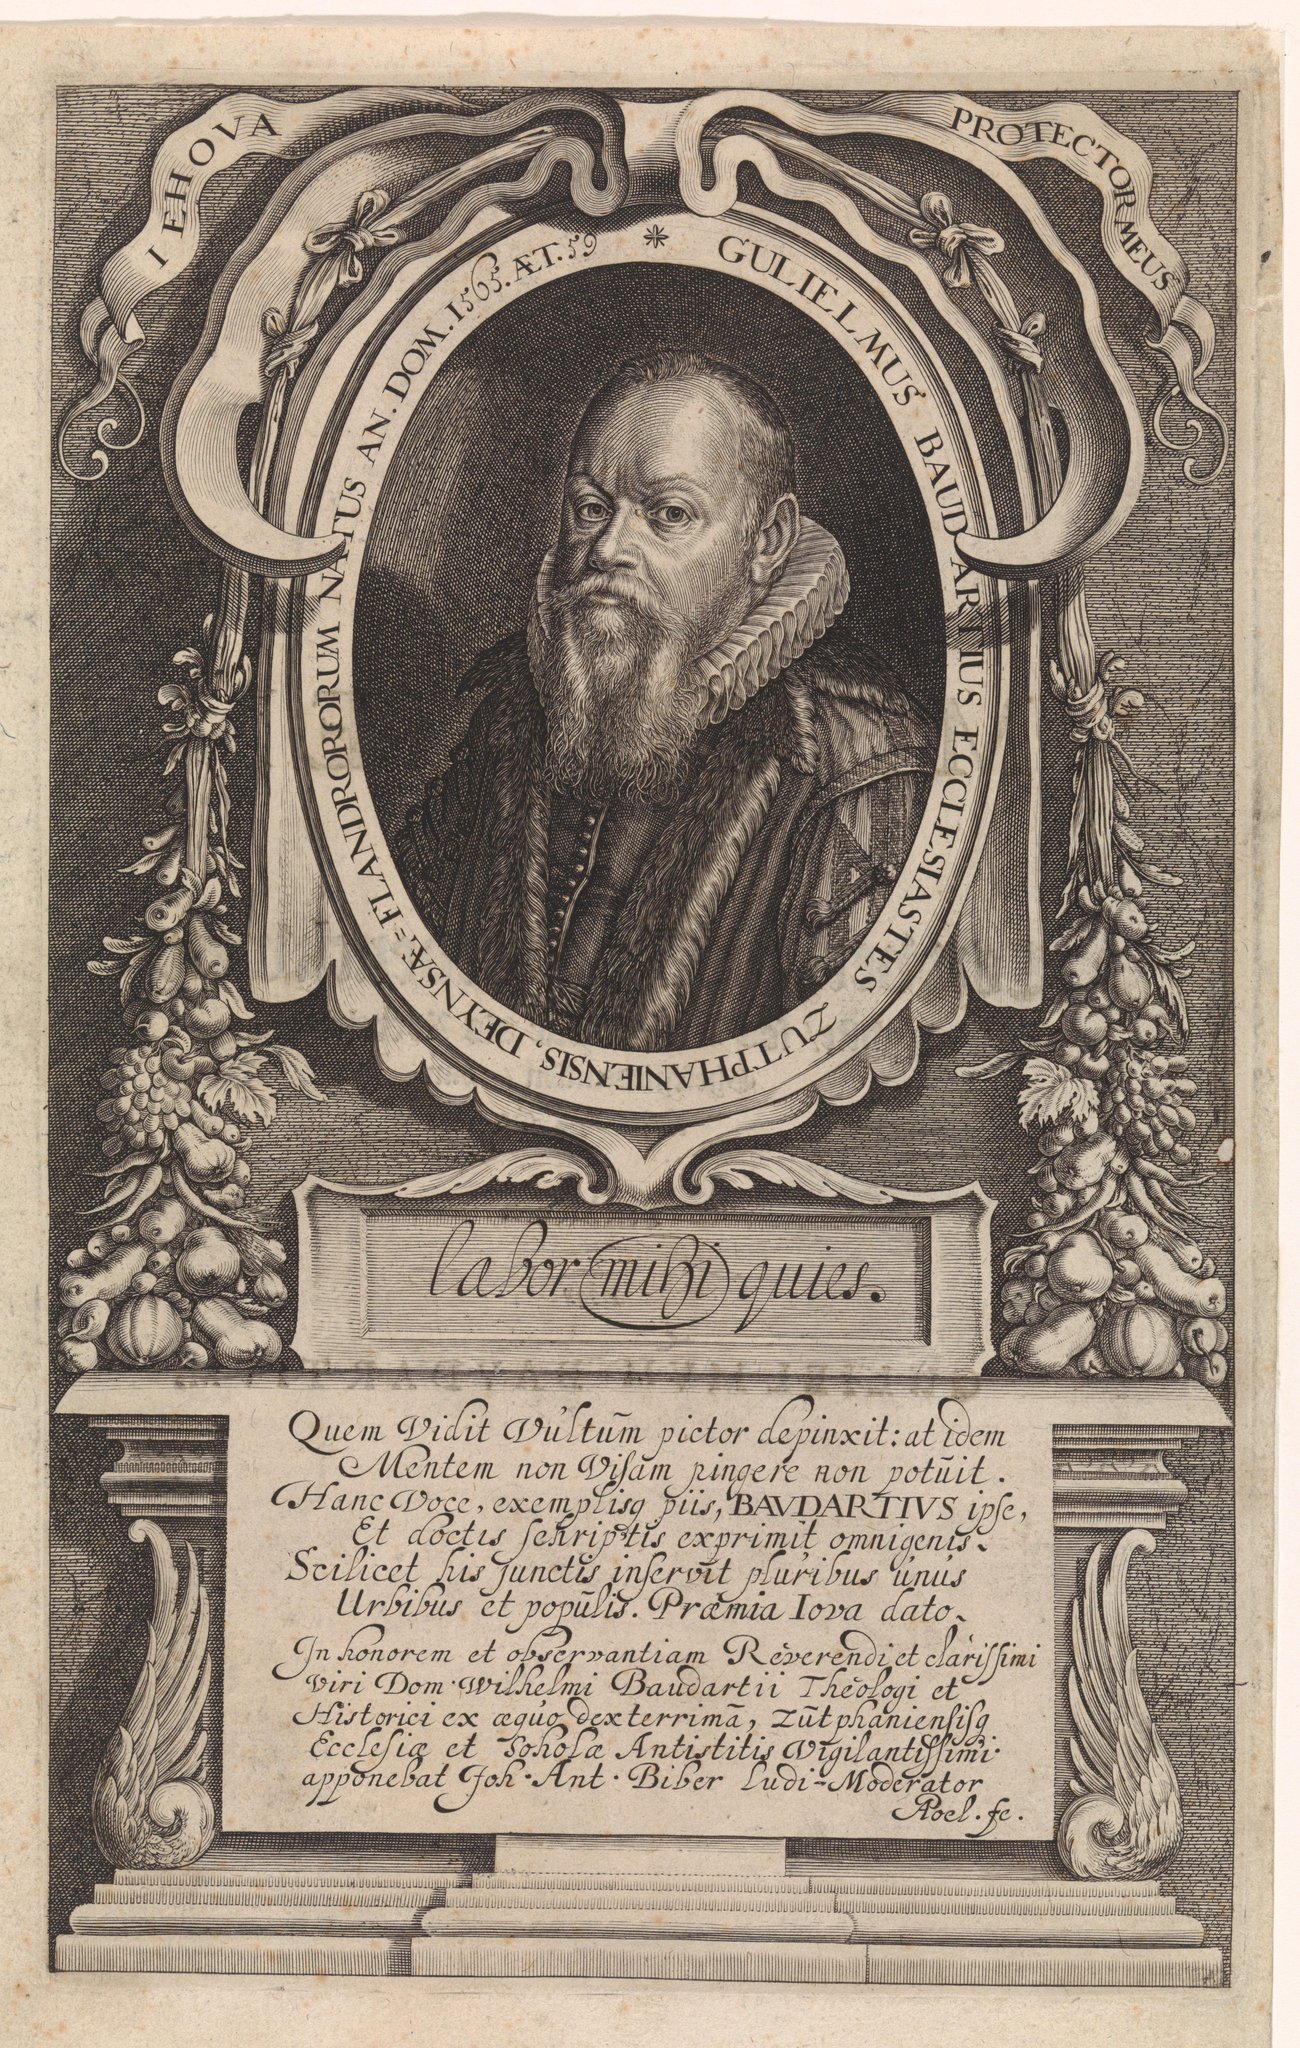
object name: print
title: Portret van Willem Baudartius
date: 1624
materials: paper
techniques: engraving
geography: arnhem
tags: deinze, zutphen (stad), theoloog, historicus, dominee, willem baudartius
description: Portret opgenomen in: Willem Baudartius. Memoryen ofte Cort verhael der gedenck-weerdichste so kercklicke als werltlicke gheschiedenissen (...) van den iaere 1603. tot in het iaer 1624. Twee delen. Tweede vermeerderde editie. Arnhem: Jan Jansz, 1624 en Zutphen: Andries Jansz van Aelst, 1624. Op versozijde Franse titelpagina.